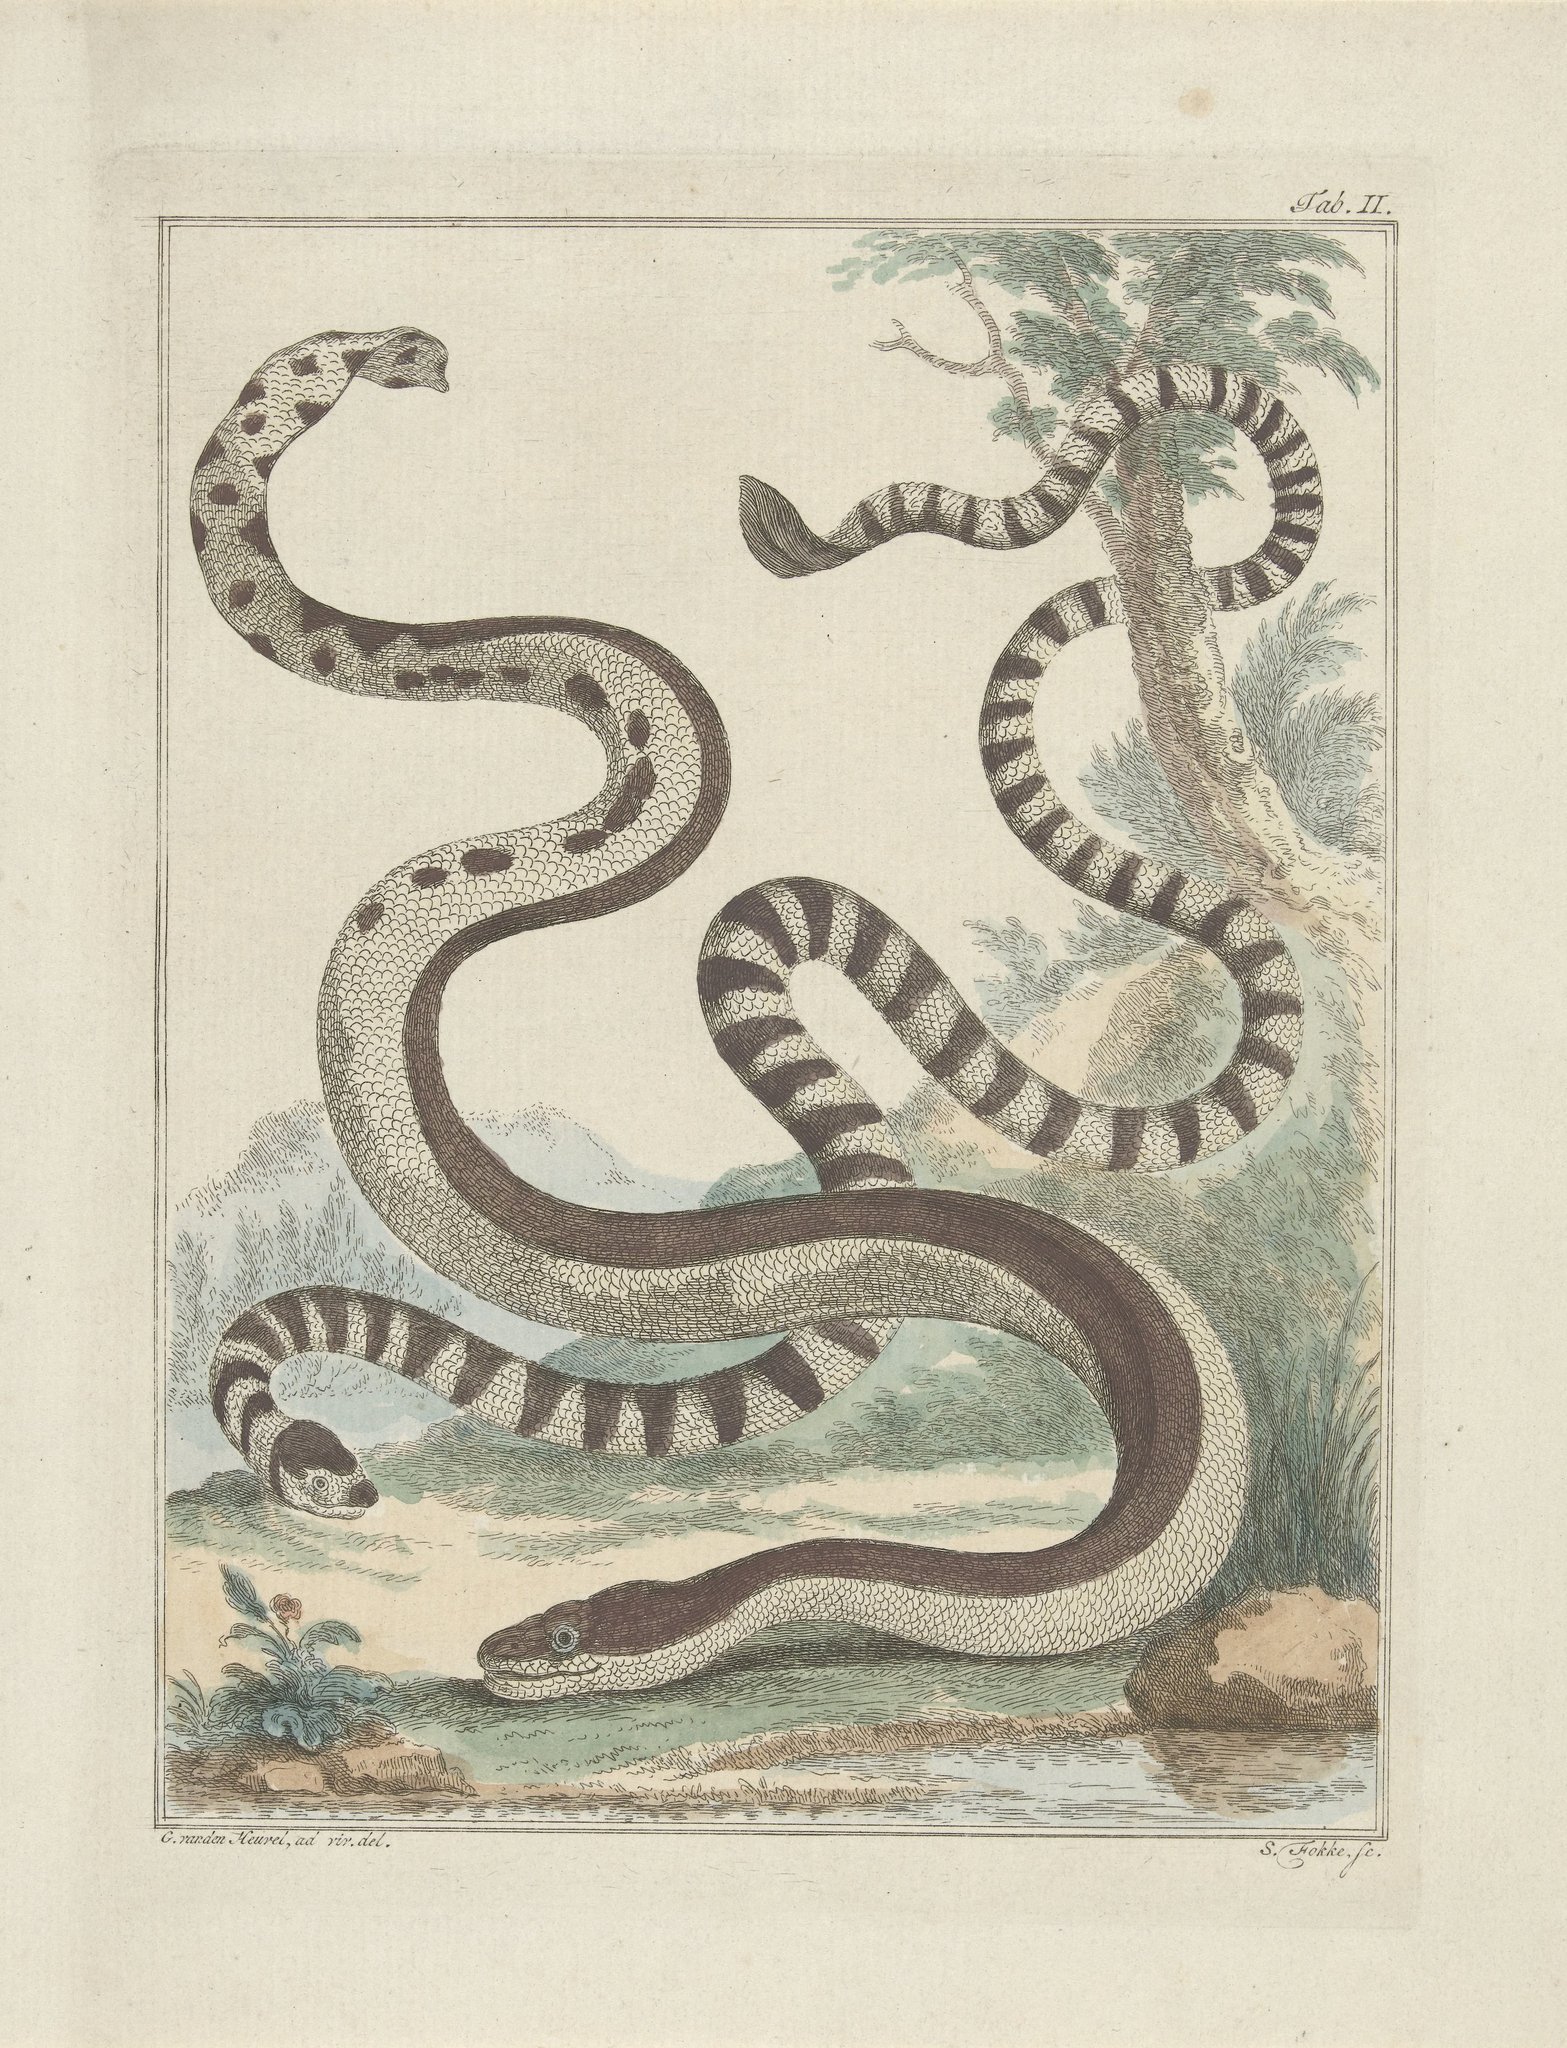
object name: print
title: Platstaartslangen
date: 1764-1784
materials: paper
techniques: etching, hand coloring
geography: amsterdam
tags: snakes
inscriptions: collector's mark: Lugt 2228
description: Kopie naar prent in: Vosmaer, Arnouth. Natuurkundige beschryving eener uitmuntende verzameling van zeldsaame gedierten : bestaande in Oost- en Westindische viervoetige dieren, vogelen en slangen : weleer leevend voorhanden geweest zynde, buiten den Haag, op het Kleine Loo van Z.D.H. den Prins van Oranje-Nassau. Amsterdam: J.B. Elwe, 1804.